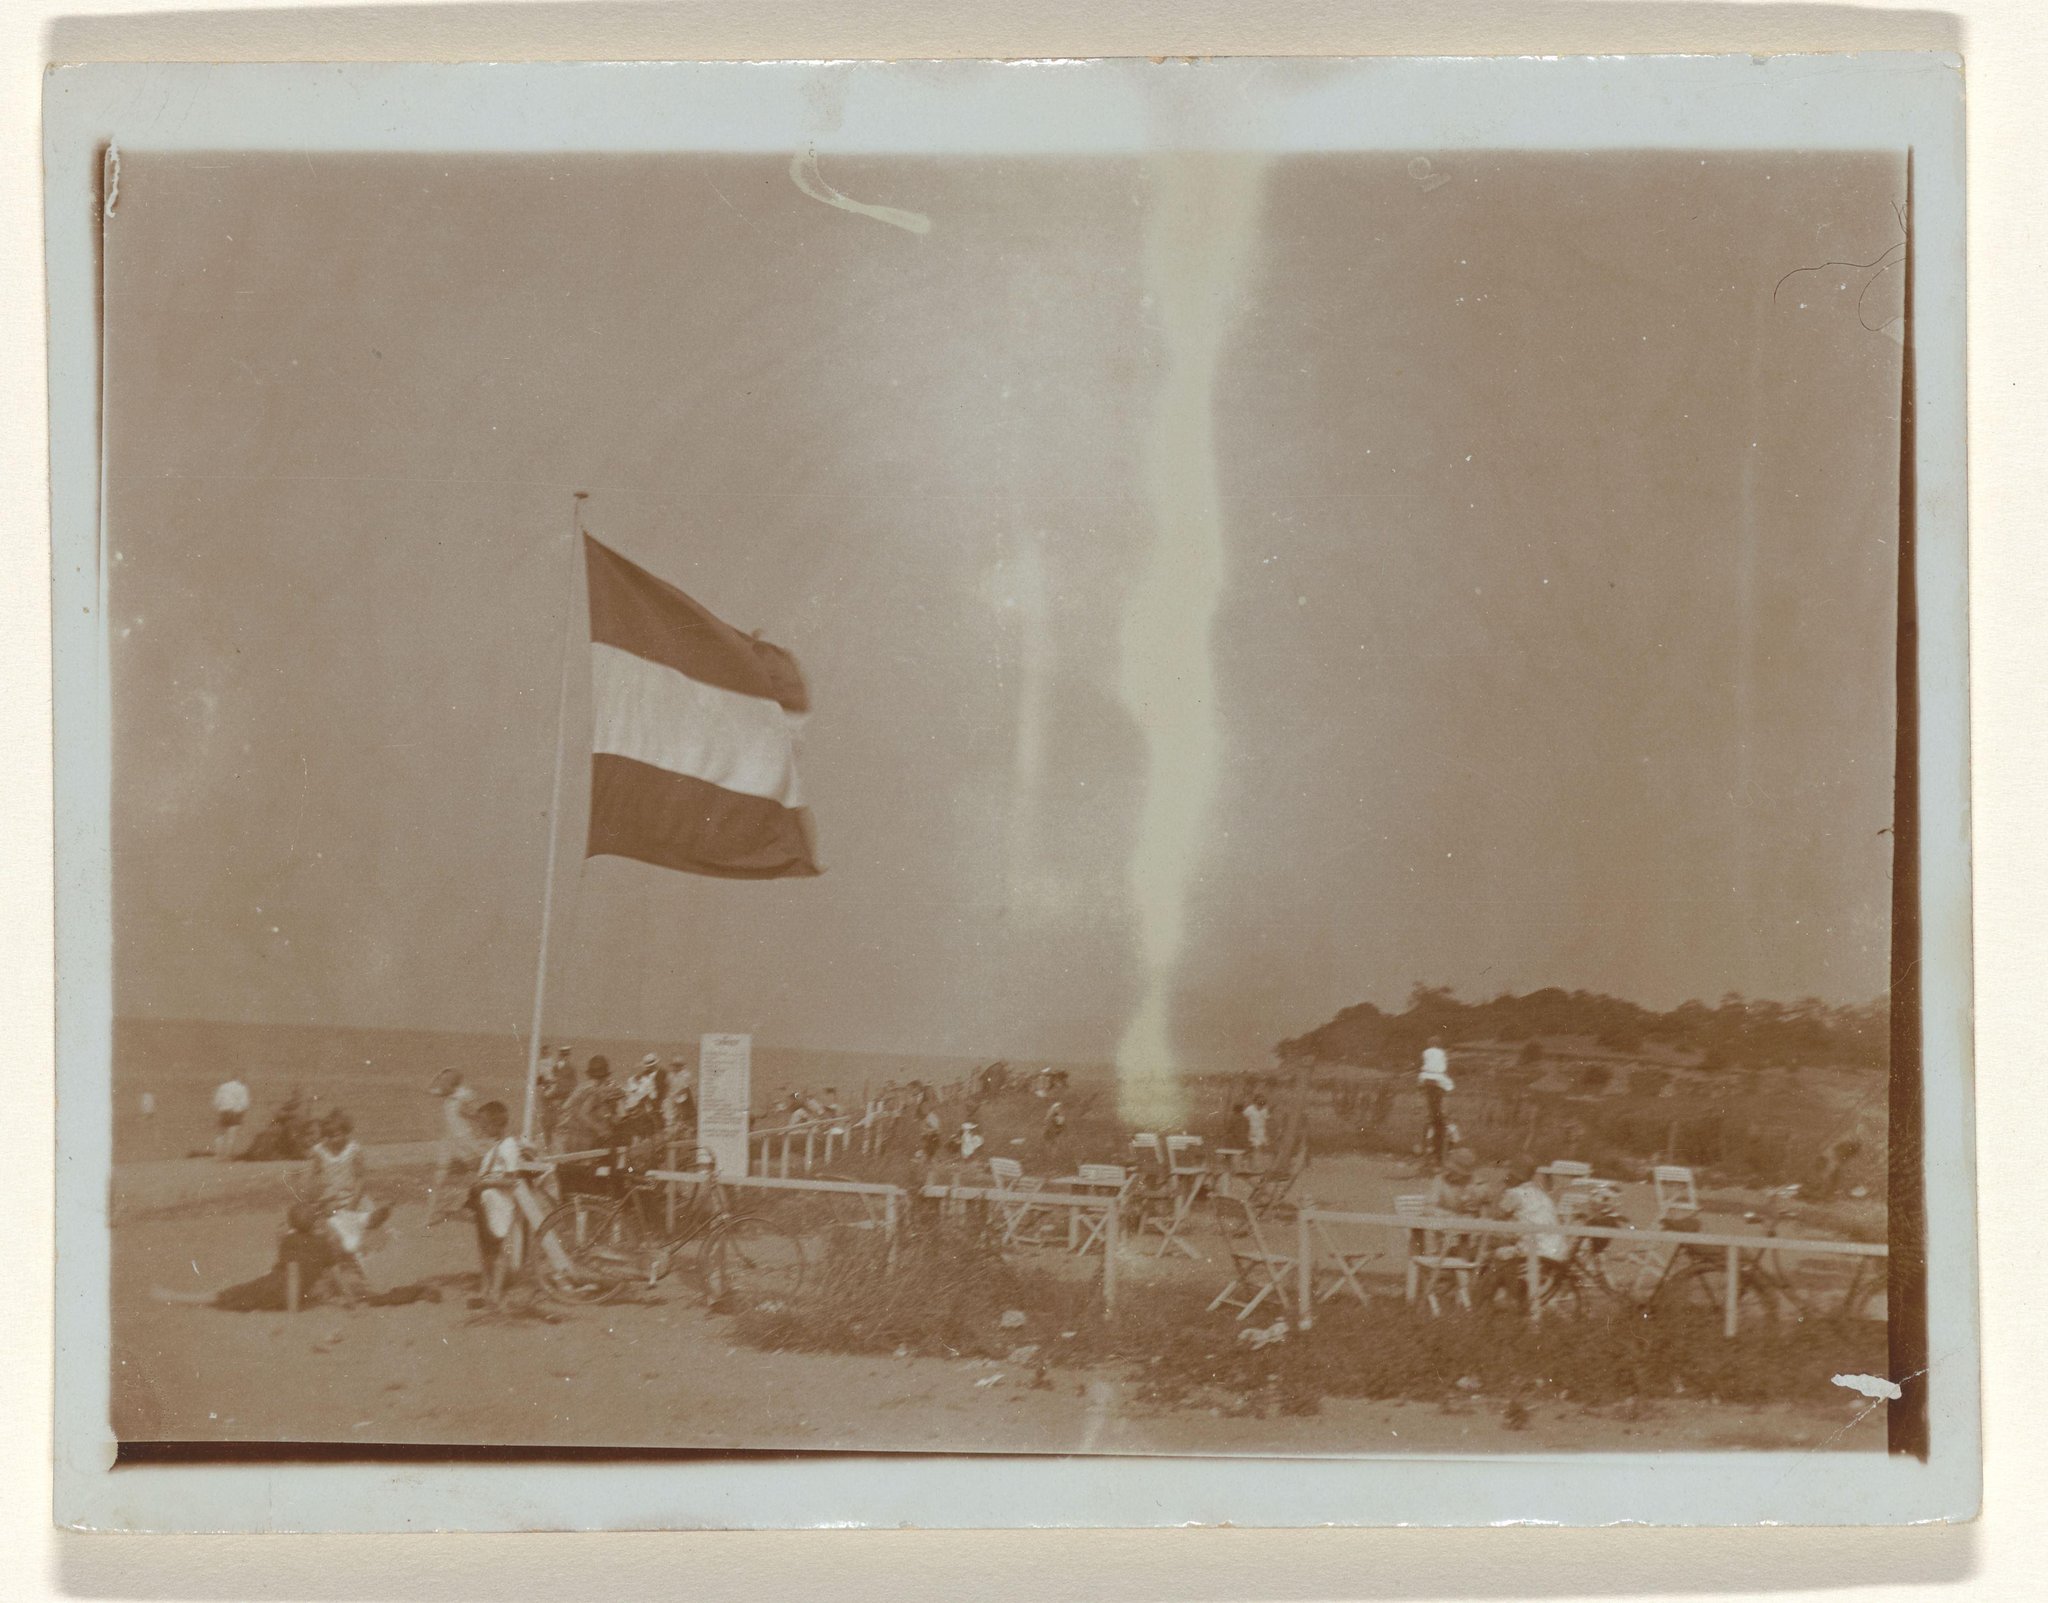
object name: photograph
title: Strand bij Valkeveen met de Nederlandse vlag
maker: Anonymous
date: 1925-1950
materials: paper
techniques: collodion silver print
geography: valkeveen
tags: beach (as place of recreation), flag, colours (as symbol of the state, etc.)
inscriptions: inscription: ‘o’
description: Strand bij Valkeveen. Op de voorgrond een met palen omheind gedeelte dat enigszins begroeid is. Op één van de hoeken van de omheinng staat een vlaggepaal met daaraan de Nederlandse vlag.